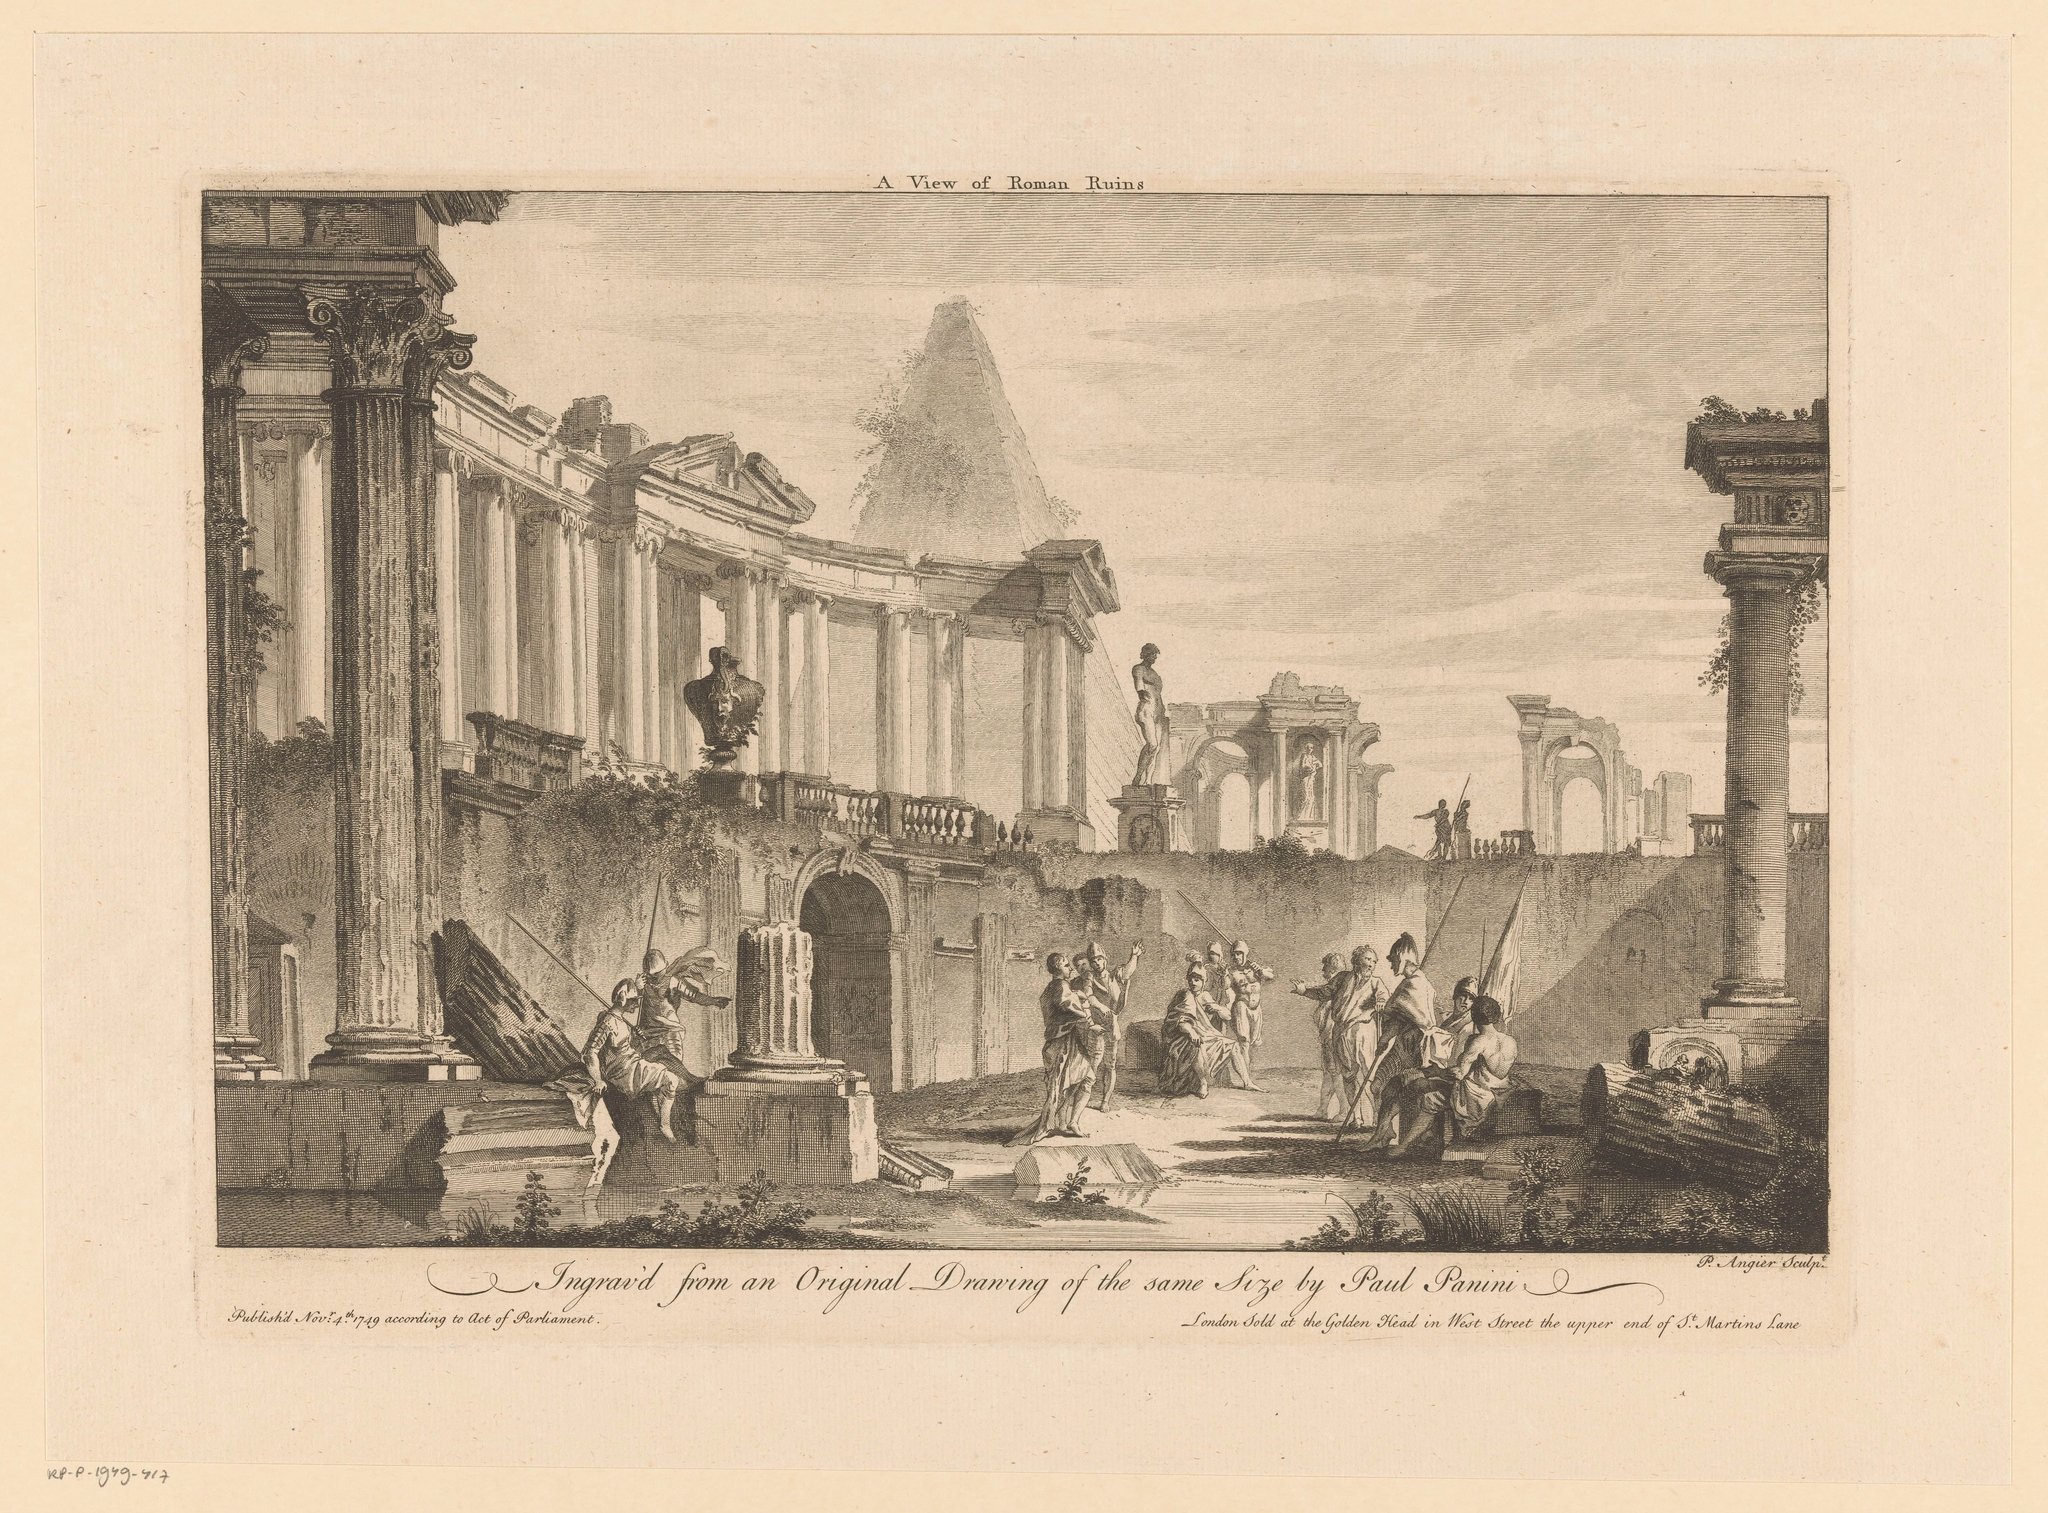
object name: print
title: A View of Roman Ruins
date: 1749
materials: paper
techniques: engraving, etching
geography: london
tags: standing figure, landscape with ruins, sculpture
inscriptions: collector's mark: Lugt 2228